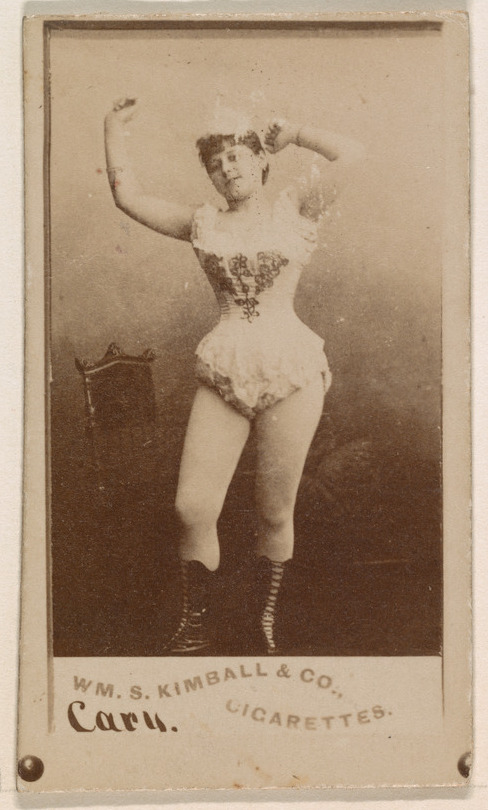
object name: photograph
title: Miss Cary, from the Actresses series (N203) issued by Wm. S. Kimball & Co.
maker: william s. kimball & company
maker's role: publisher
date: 1889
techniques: color lithograph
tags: portraits,women,actresses